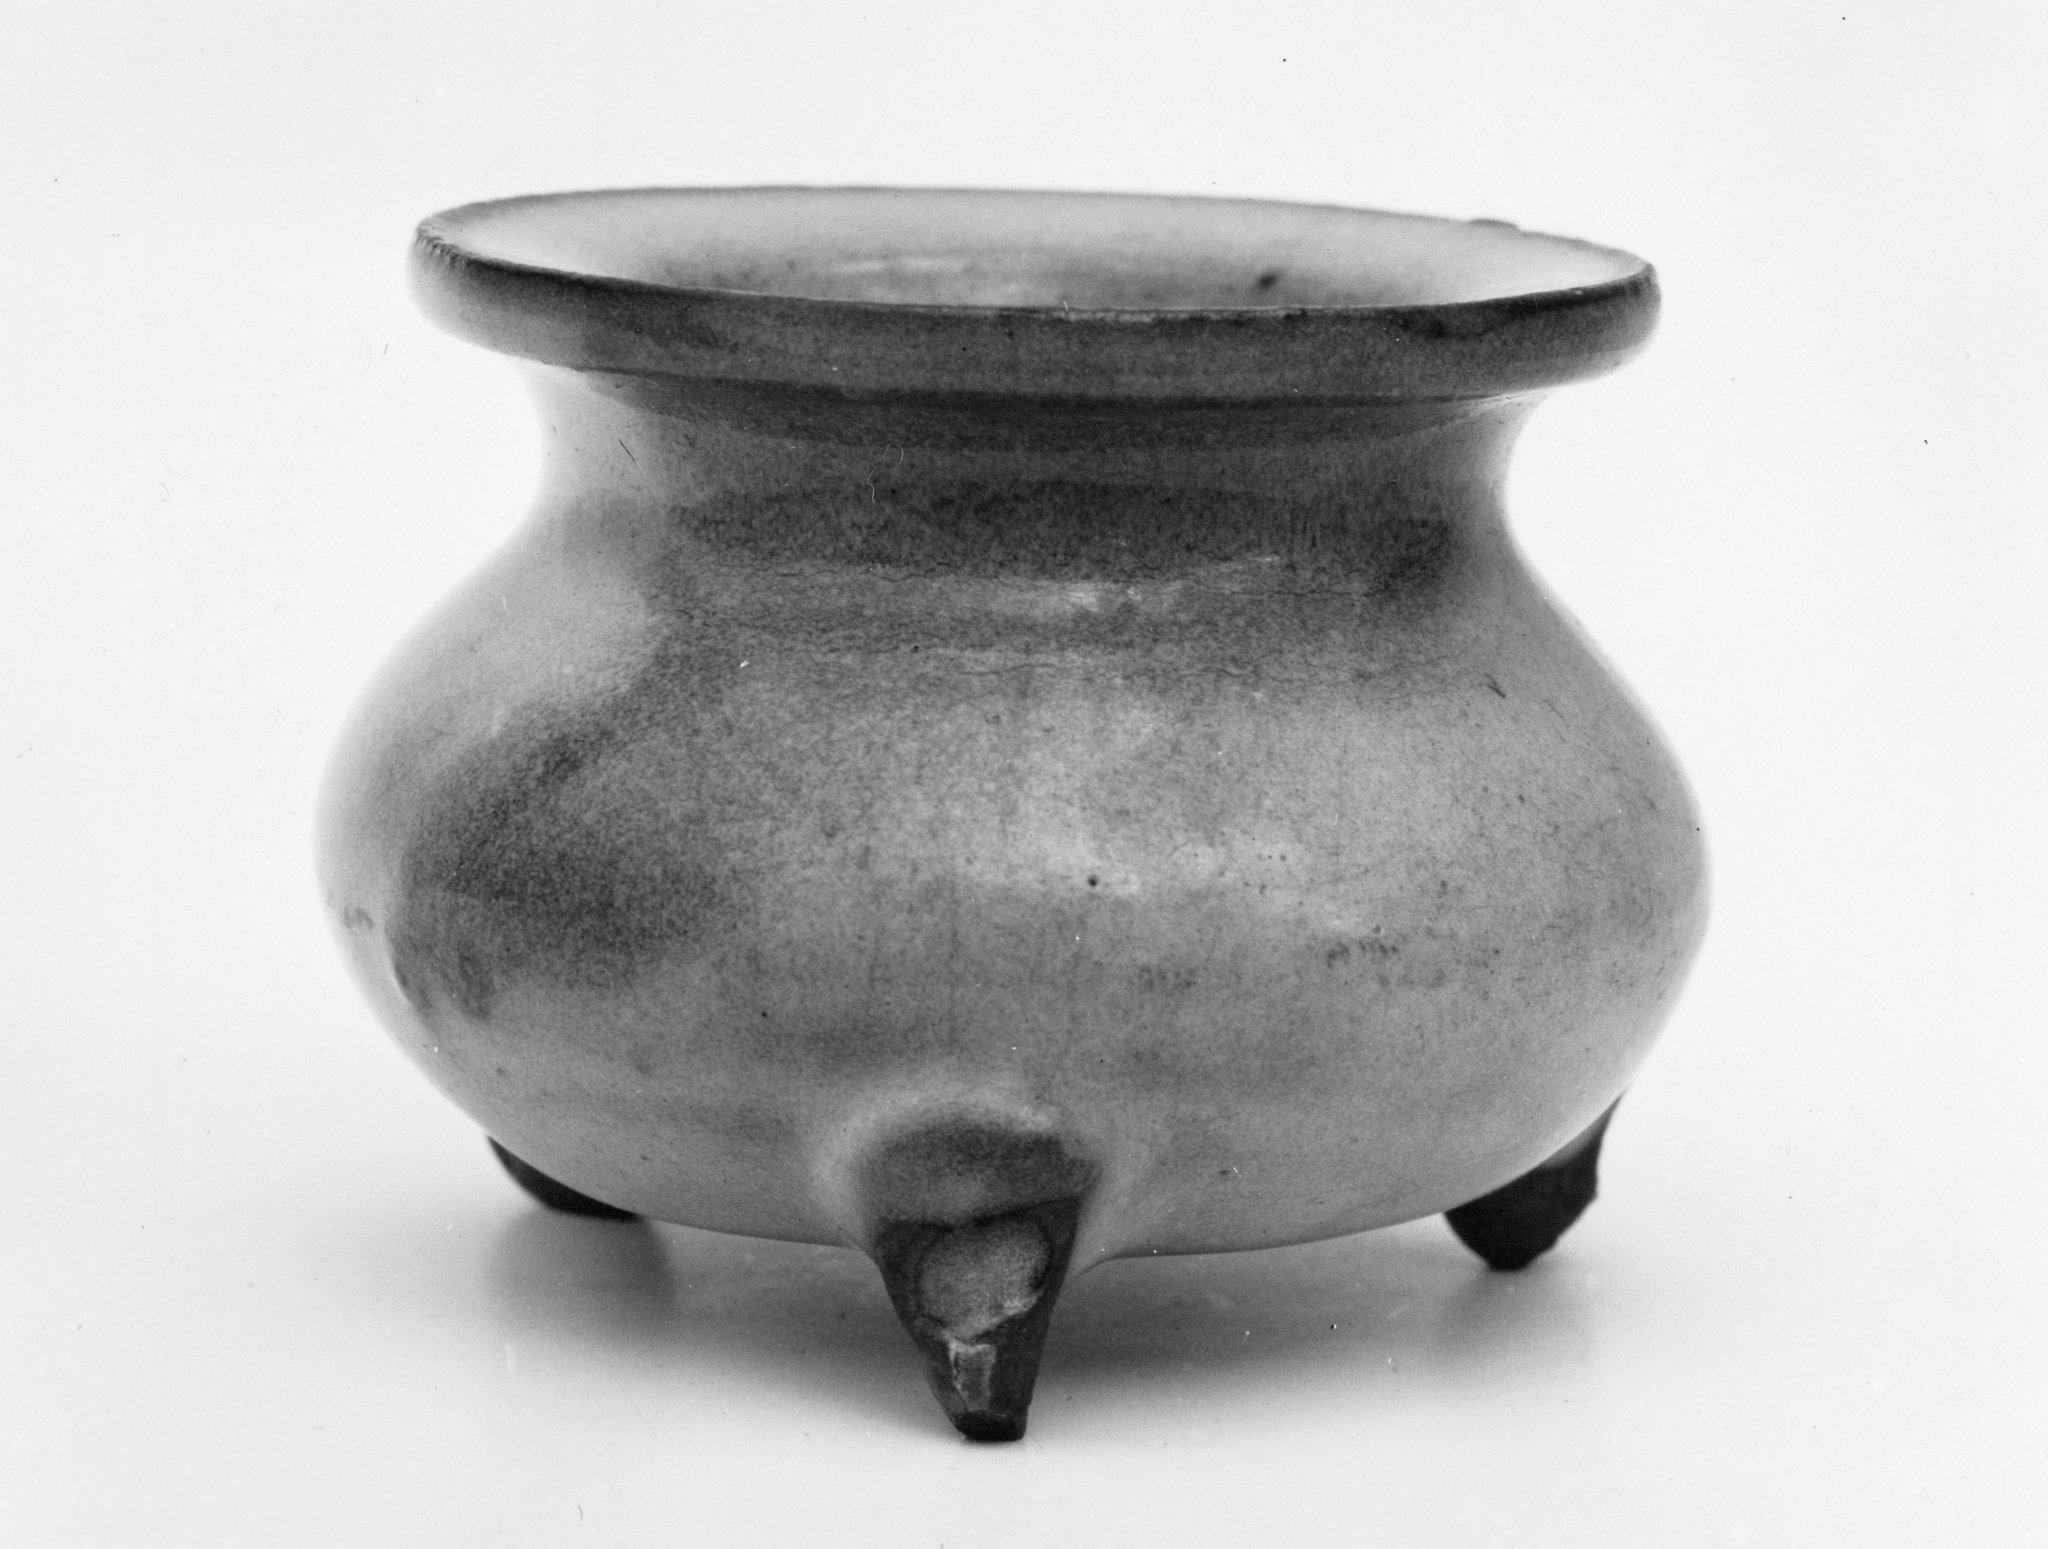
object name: incense burner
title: Miniature tripod incense burner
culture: chinese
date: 1115-1368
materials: glaze, stoneware